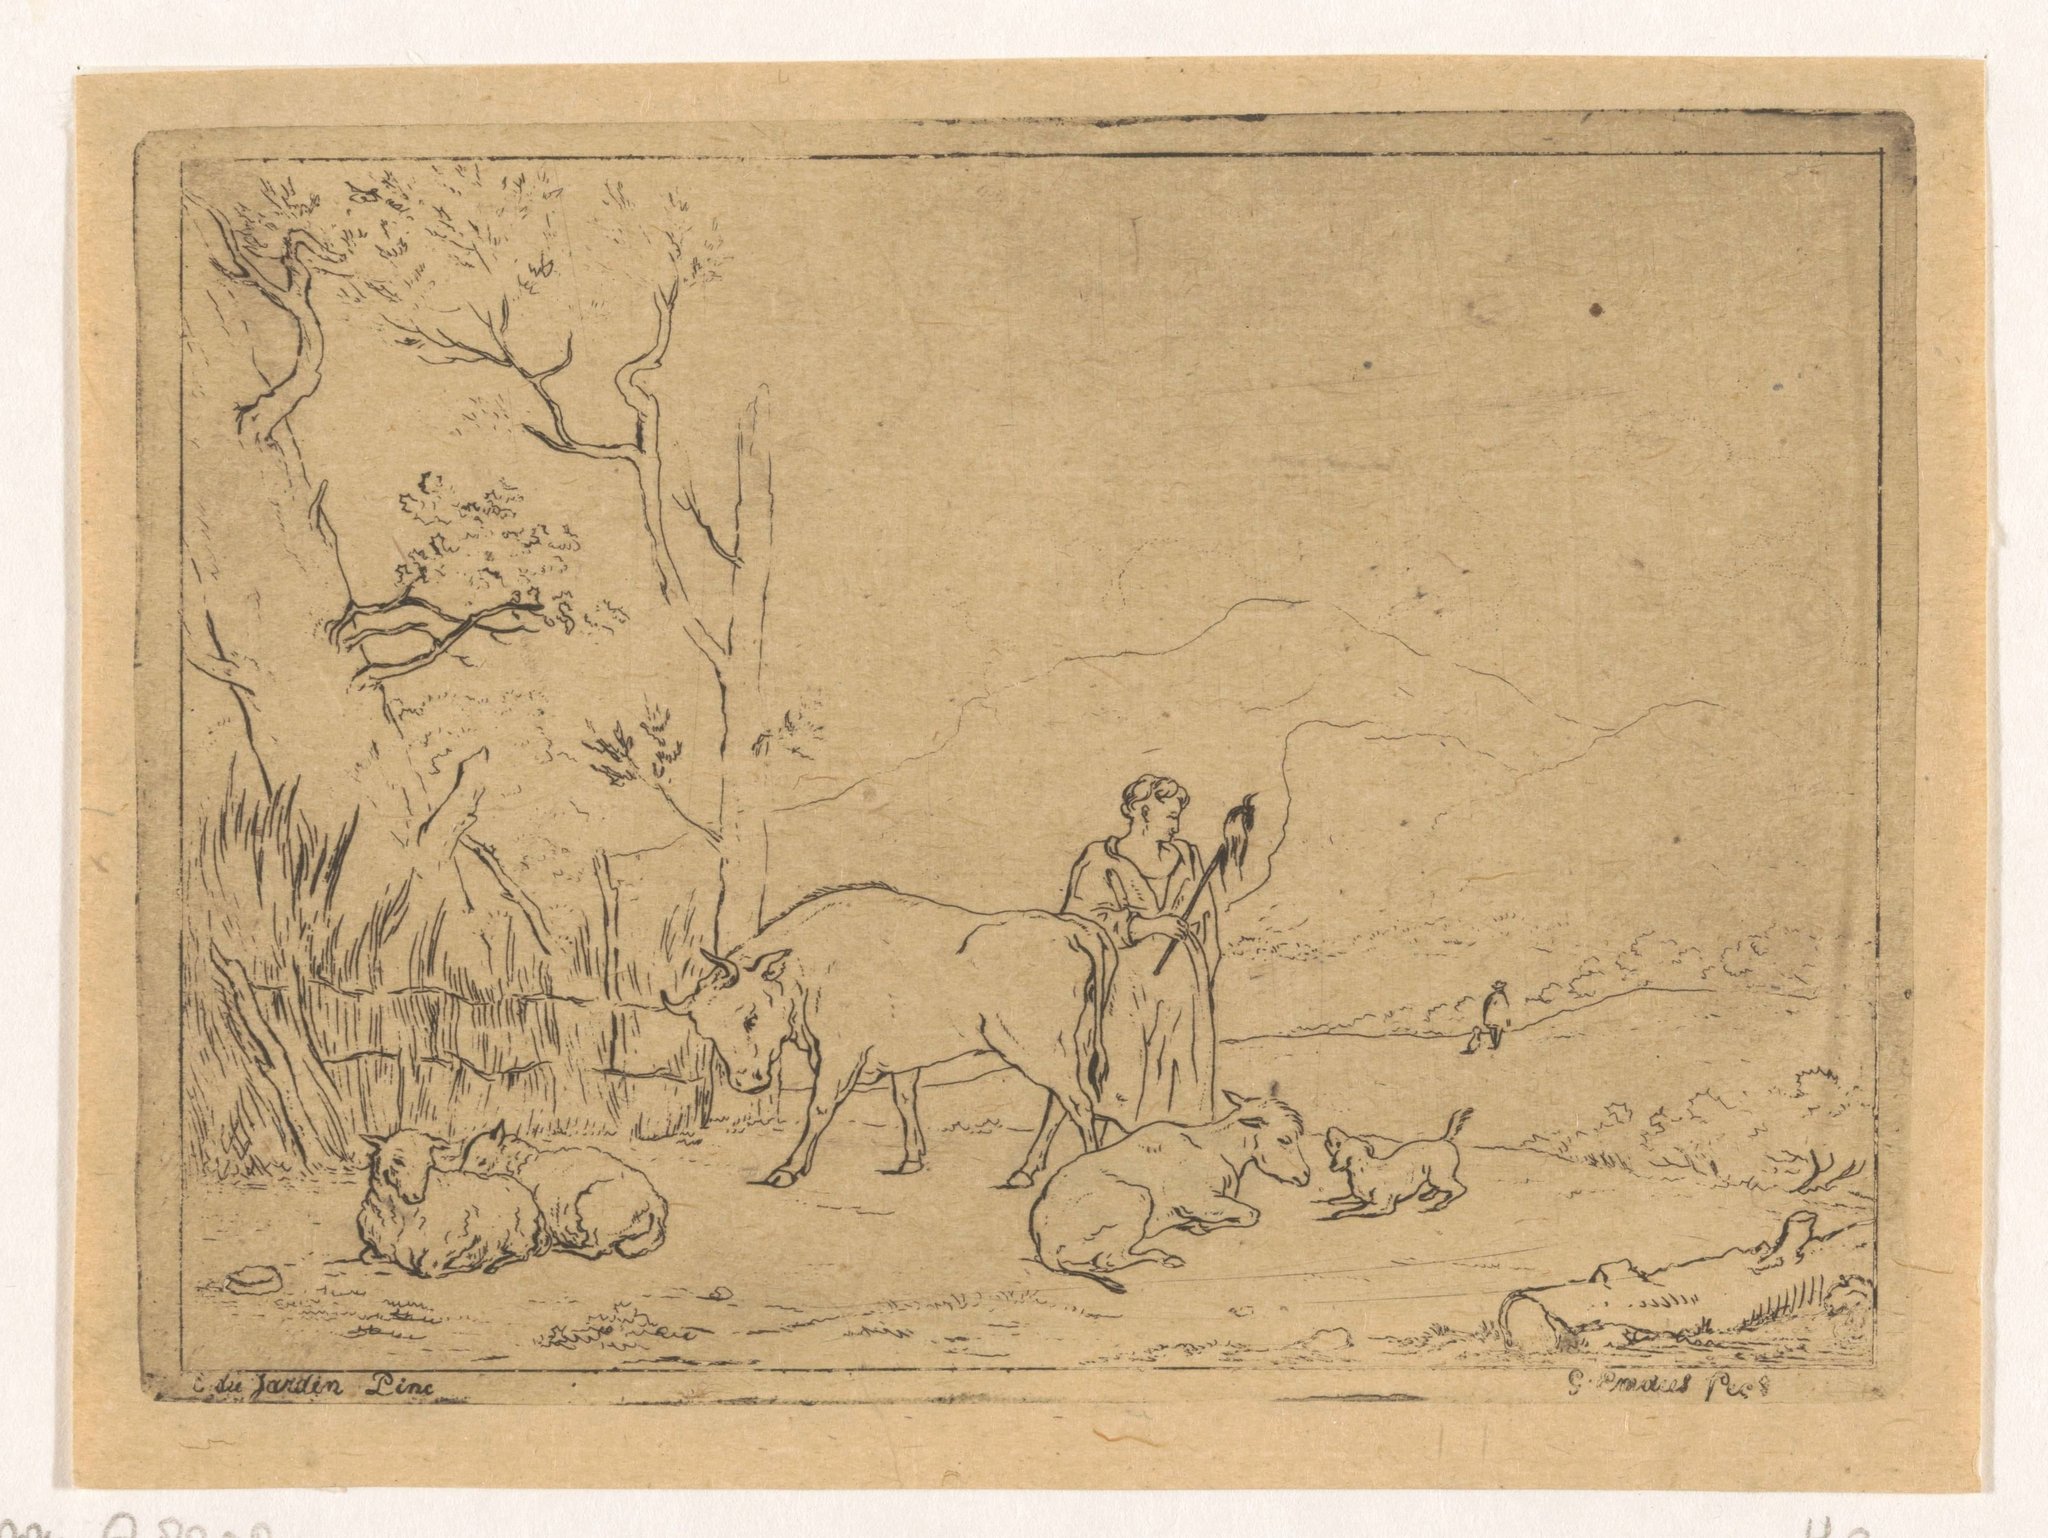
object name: print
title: Spinnende herderin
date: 1813-1863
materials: paper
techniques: etching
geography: netherlands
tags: spinning (manufacture of yarn)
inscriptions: collector's mark: Lugt 2228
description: In een berglandschap met bomen, zit een vrouw met een spintol in haar hand. Vóór haar blaft een hond naar een kalfje en kijkt een koe in de richting van twee schapen.